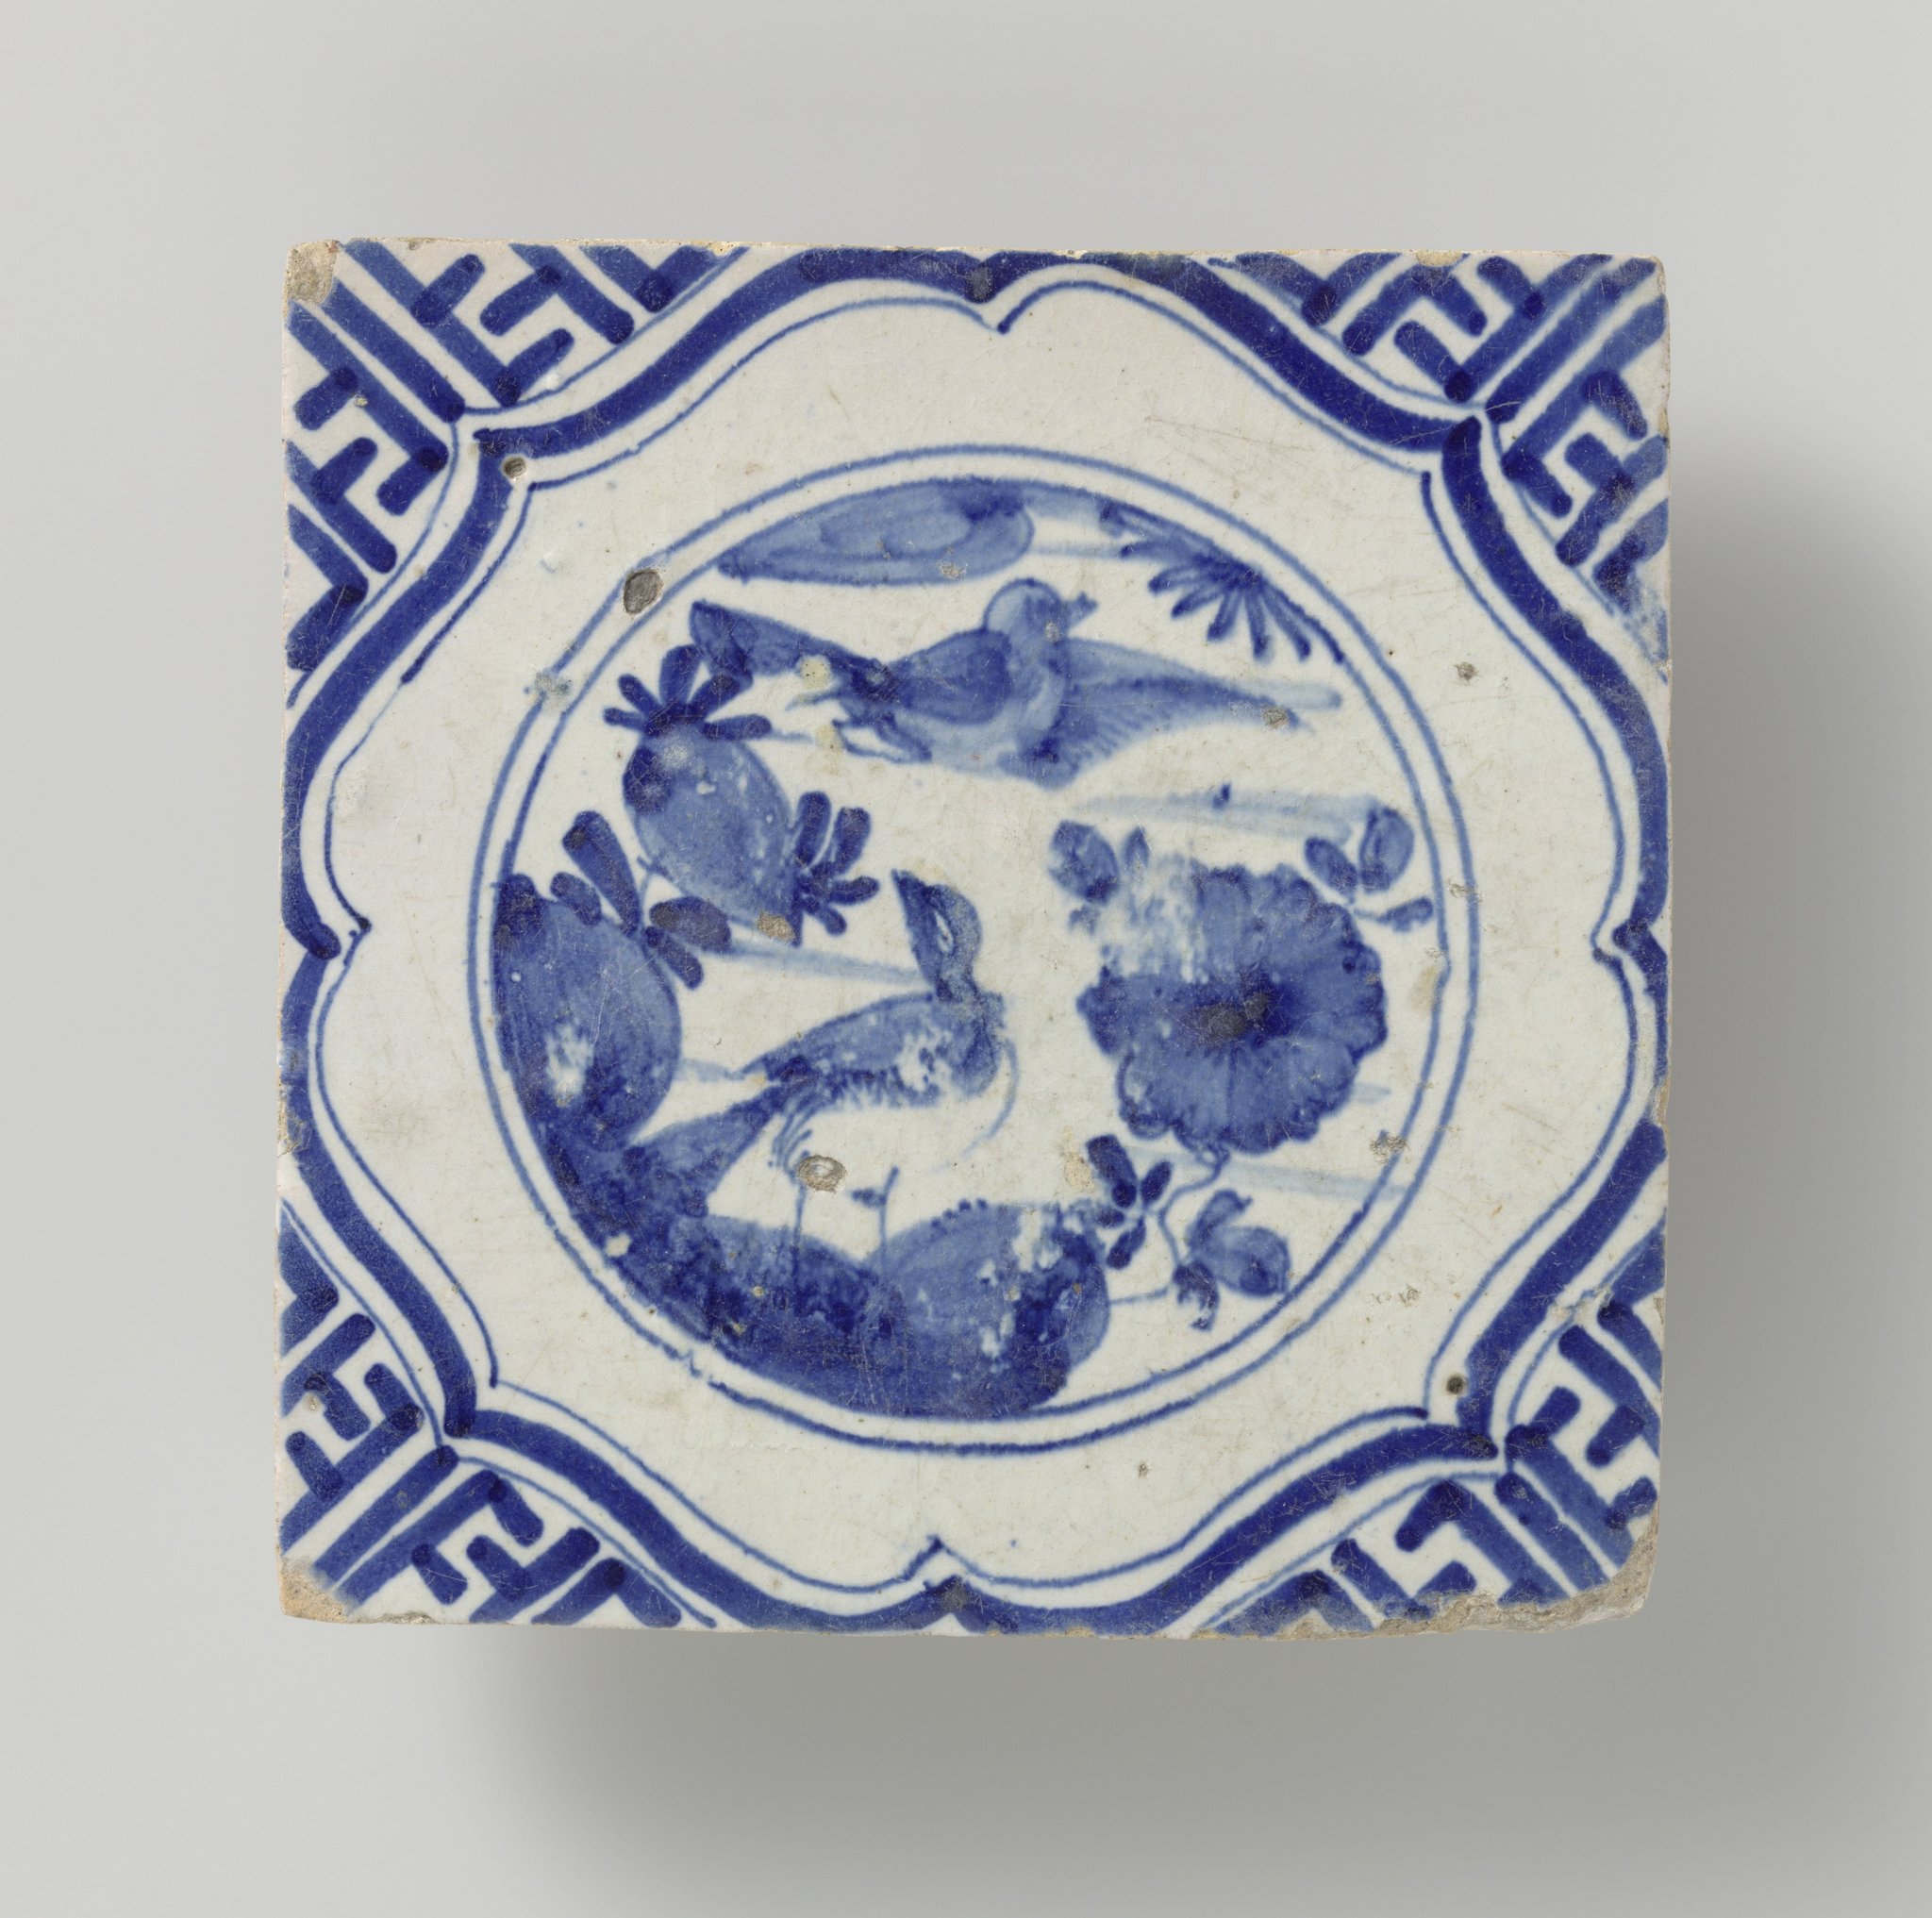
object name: tile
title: Tegel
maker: Anonymous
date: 1620-1640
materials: earthenware, glaze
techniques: maiolica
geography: netherlands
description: Tegel met een blauw geschilderde vogel in een Chinese tuin binnen een akkolade omgeven door een meander.